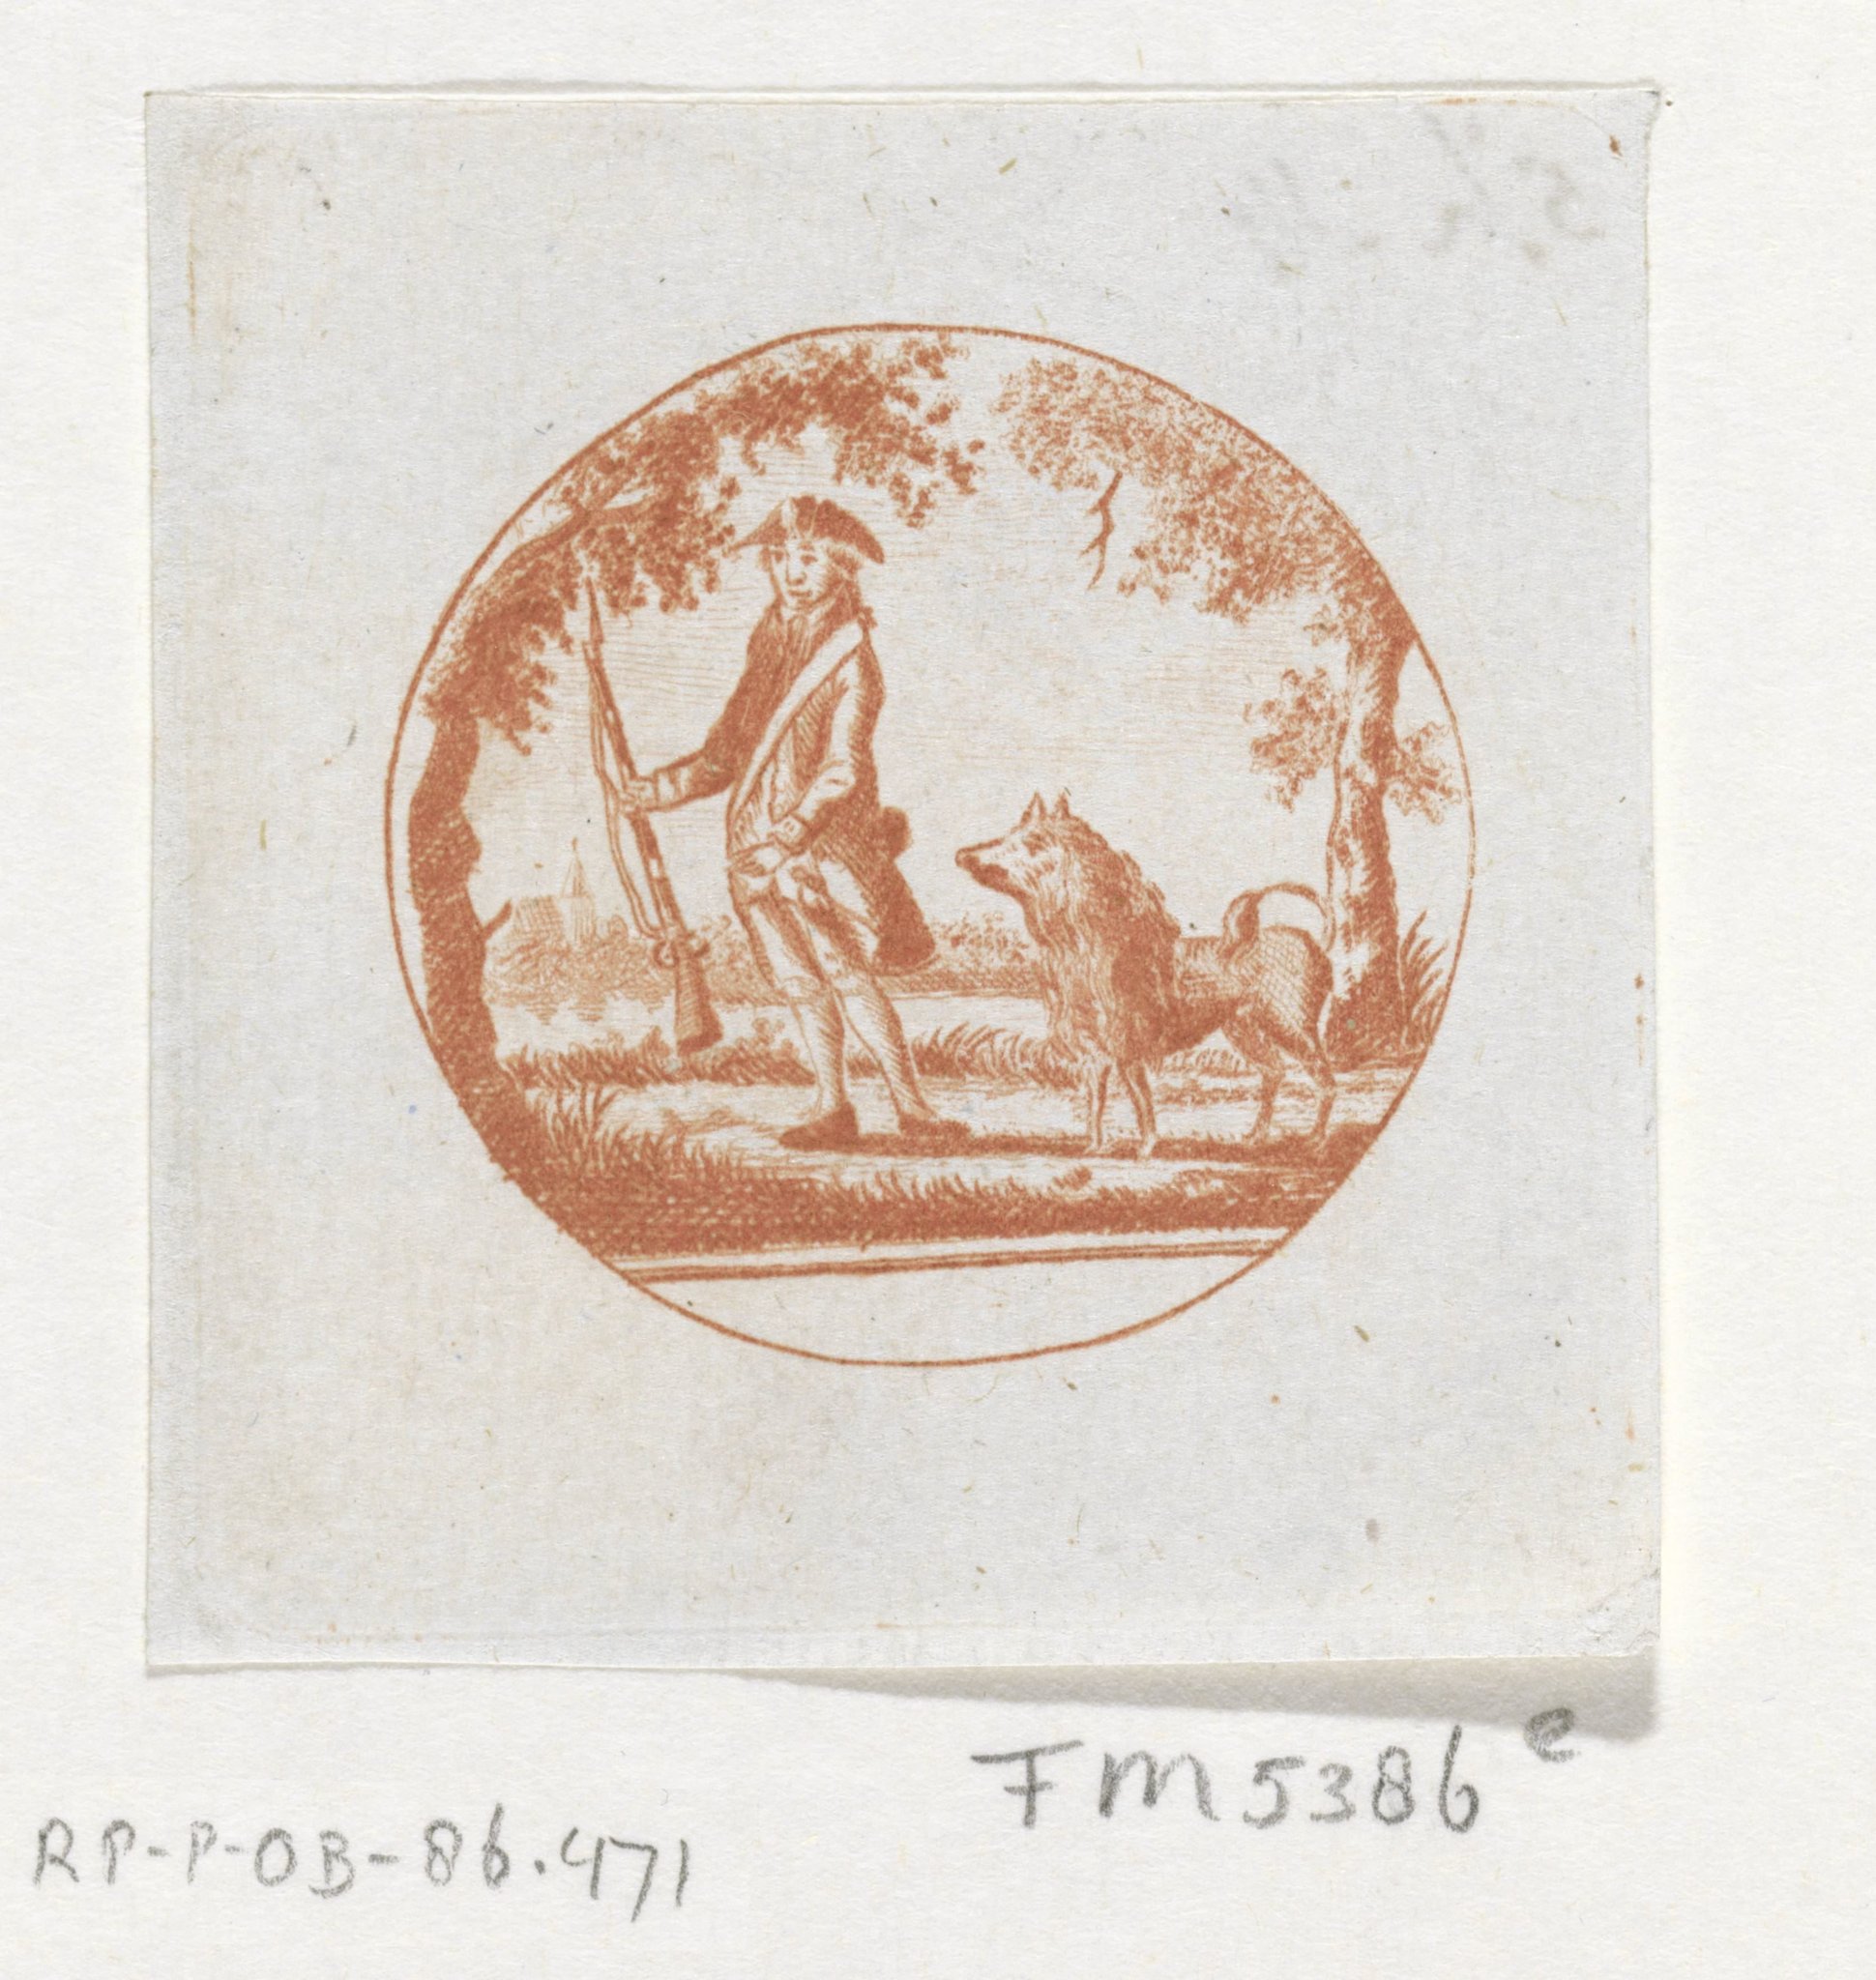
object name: print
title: Schutter met keeshond, ca. 1787-1795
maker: Anonymous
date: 1787-1795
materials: paper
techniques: engraving, etching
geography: netherlands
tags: dog, patriots (1780-1795)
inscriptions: collector's mark: Lugt 2228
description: Rond vignet met een schutter van een vrijkorps met een keeshond, ca. 1787-1795.